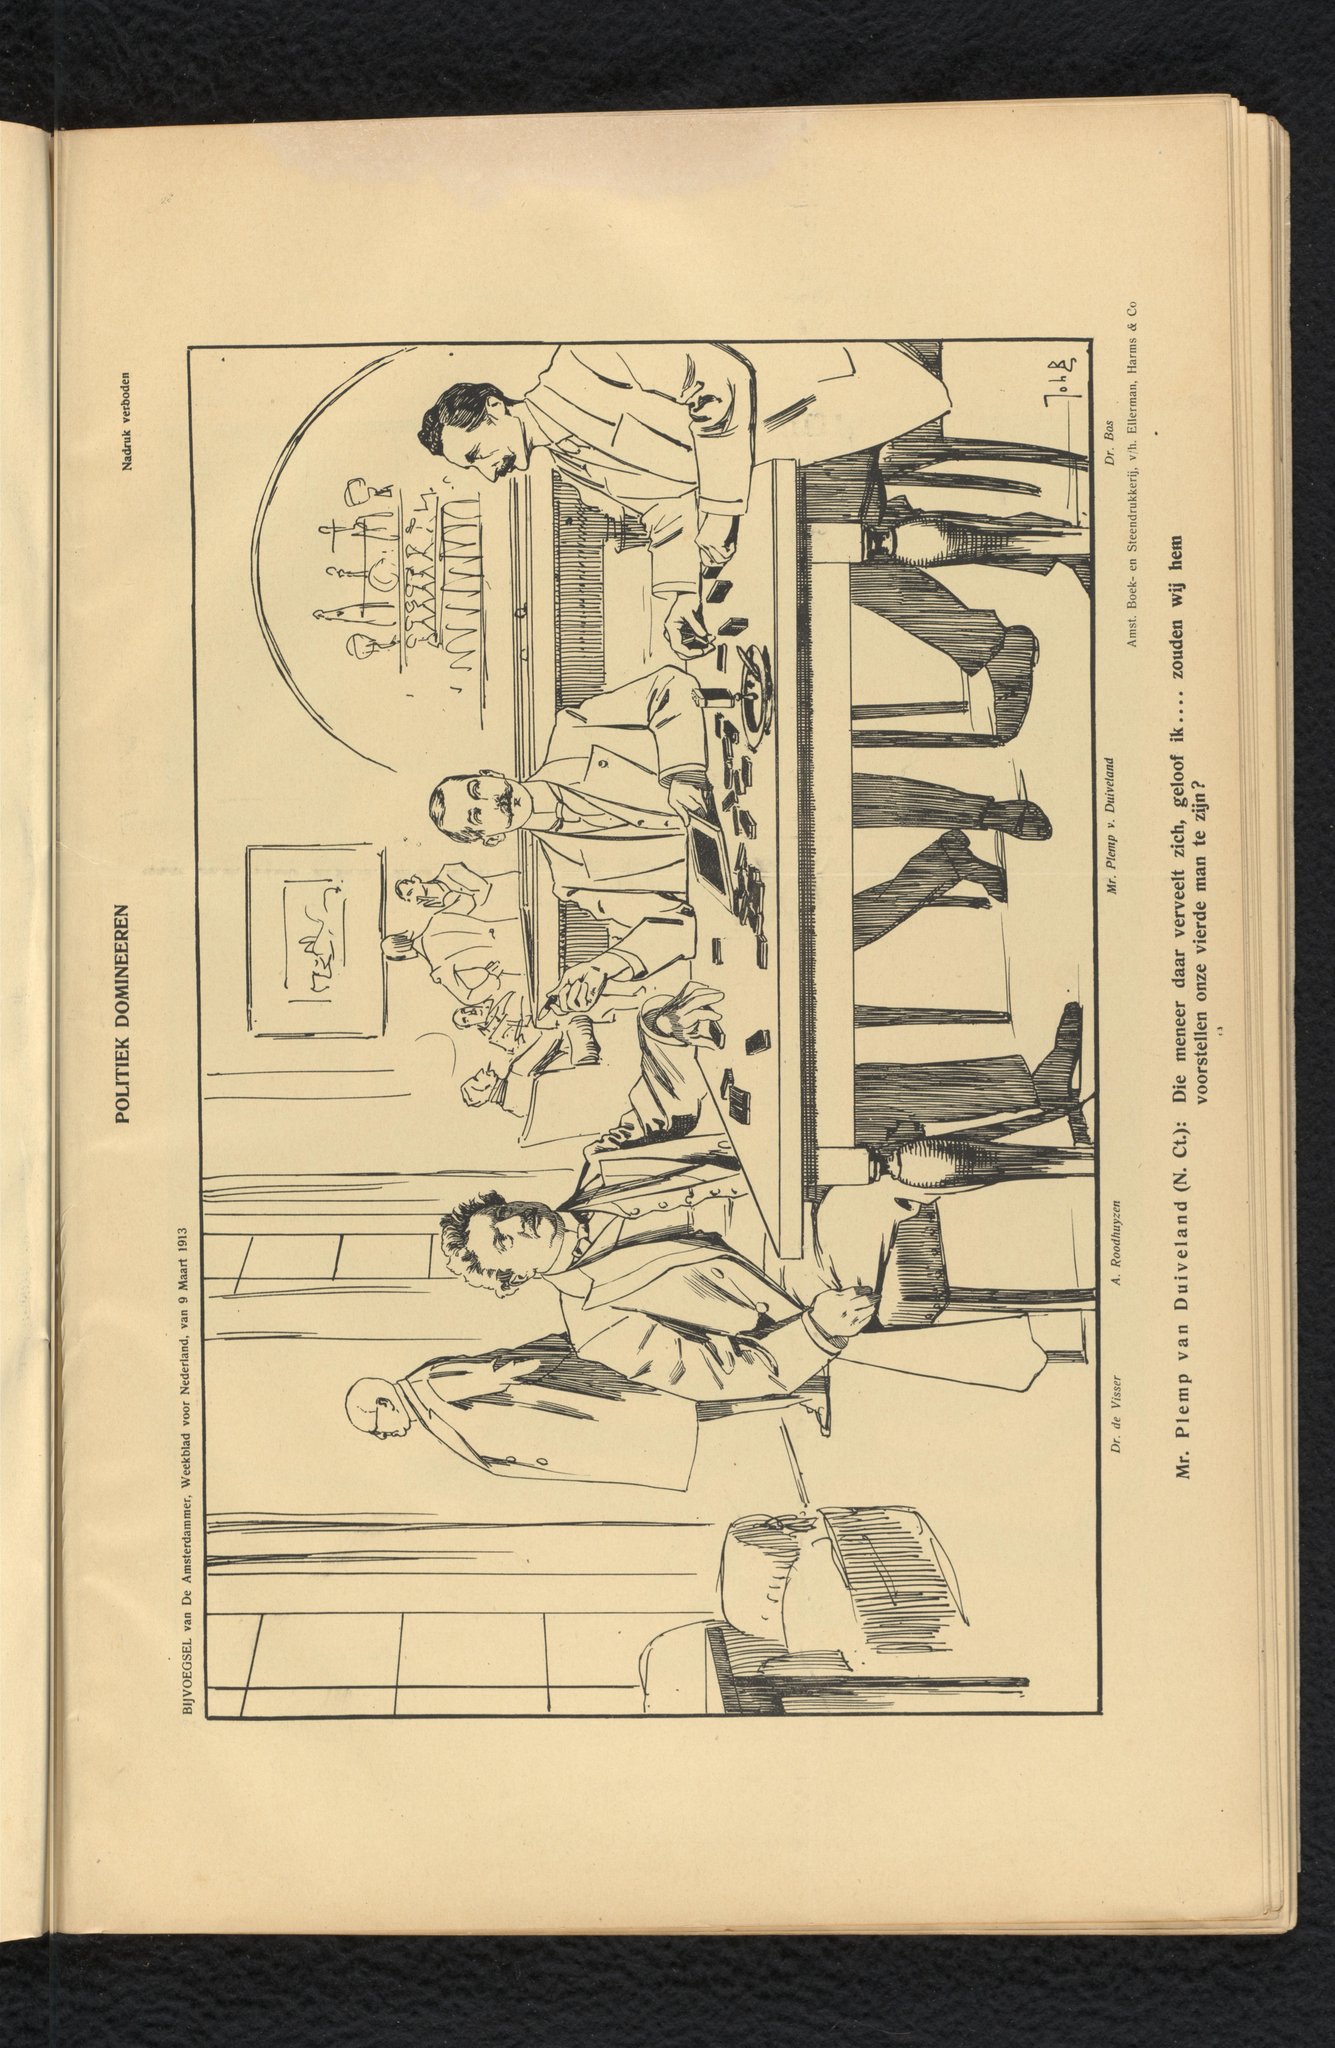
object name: cartoon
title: Politiek domineeren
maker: johan braakensiek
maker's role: draughtsman, print maker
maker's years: 1858-1940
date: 1913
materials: paper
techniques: lithograph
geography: amsterdam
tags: utrecht, the hague, rotterdam, club, meeting place, dominoes, political caricatures and satires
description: Op de sociëteit overwegen Roodhuyzen, Plemp van Duiveland en Bos om Johannes Theodoor de Visser te vragen als vierde man bij hun dominospel.